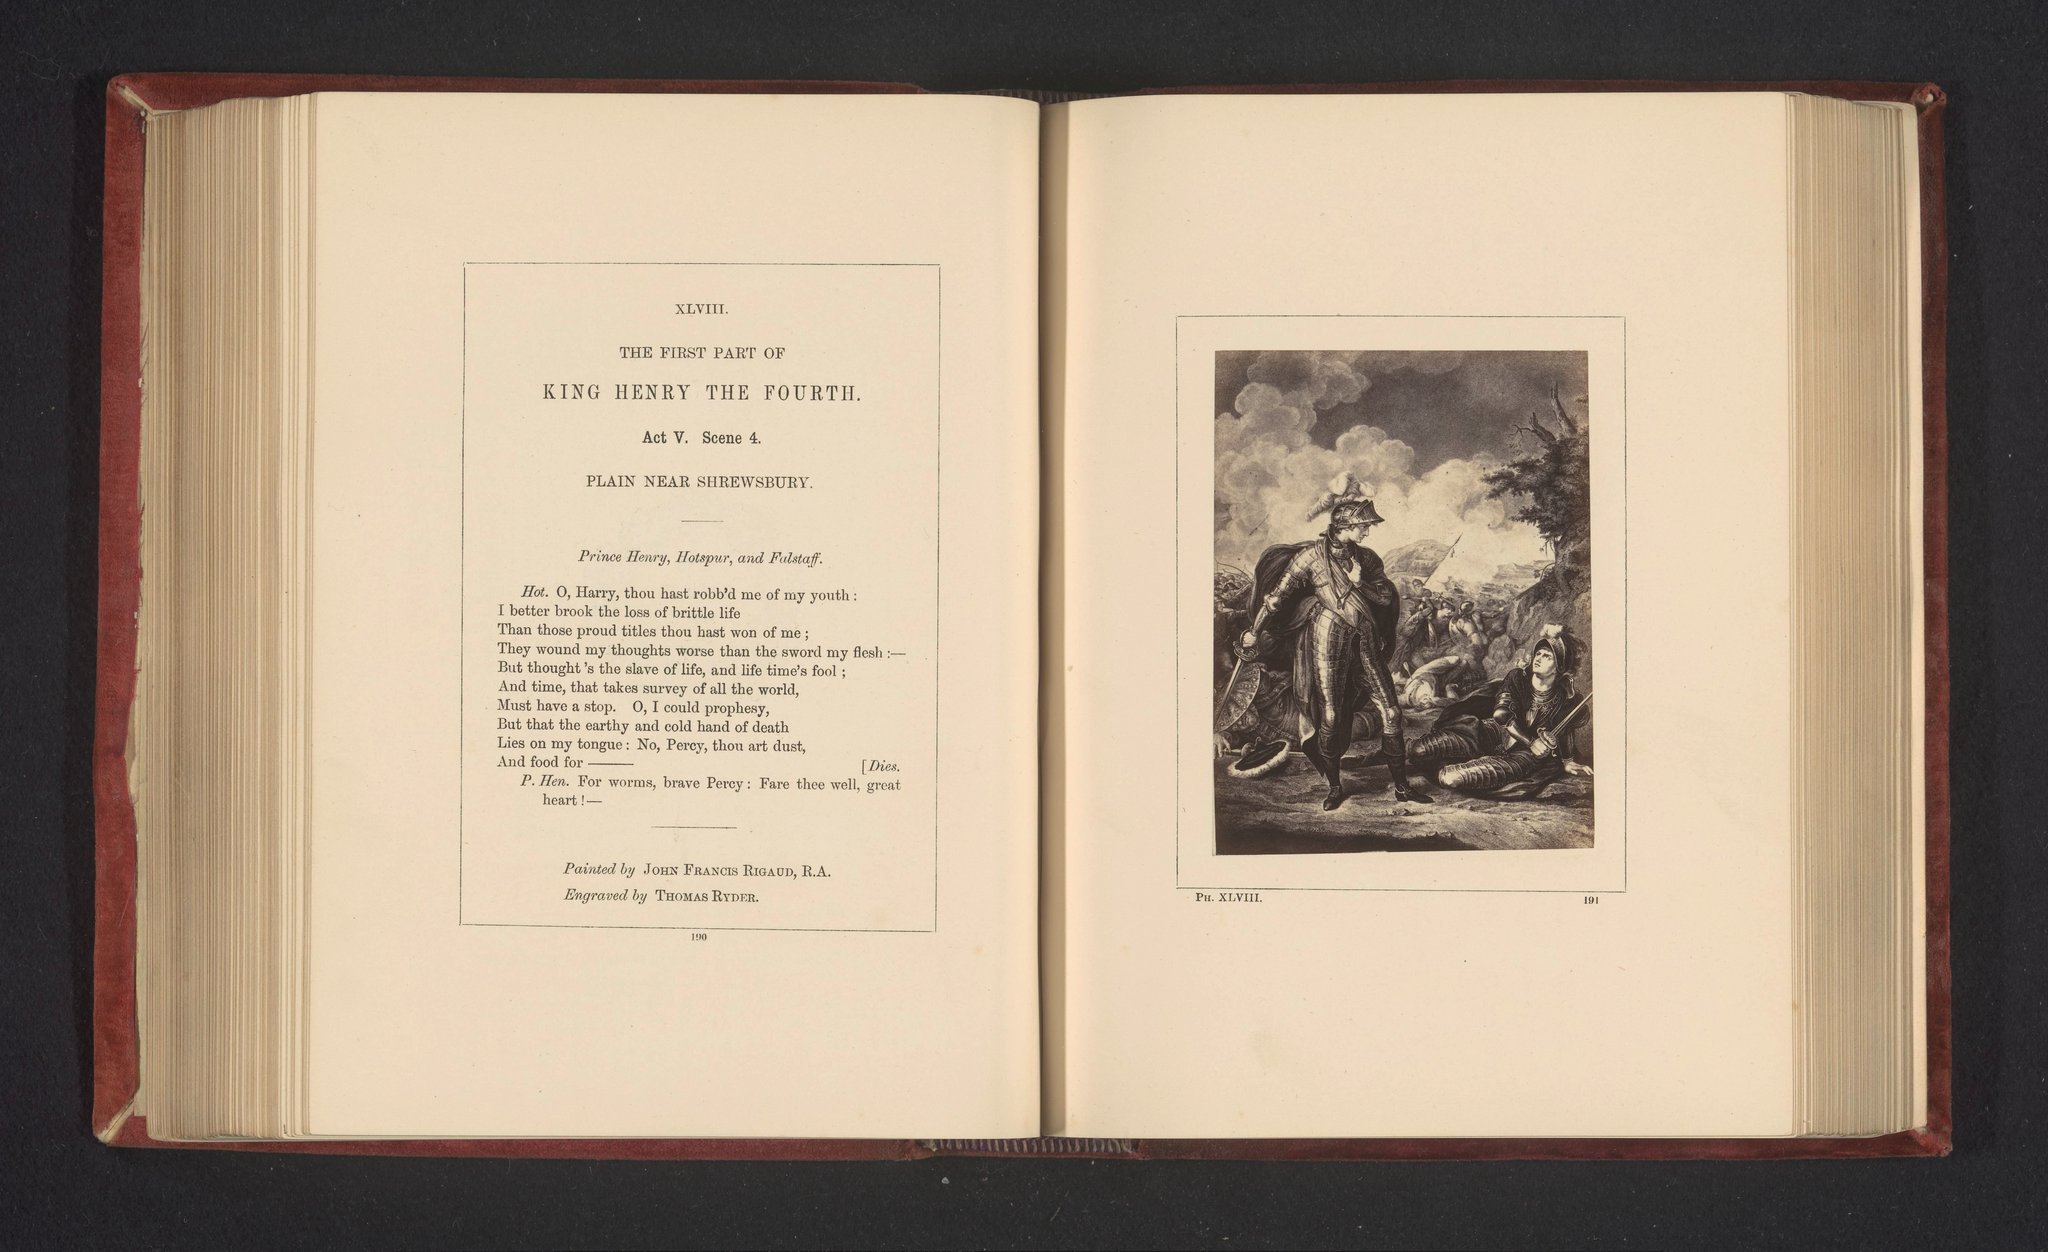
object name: page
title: Fotoreproductie van een prent naar een schilderij door John Francis Rigaud, voorstellend een scene uit Hendrik IV door William Shakespeare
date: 1854-1864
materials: photographic support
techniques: albumen print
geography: london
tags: specific works of literature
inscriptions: number: ‘Ph. XLVIII. 191’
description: Te zien is akte V, scene 4 met prins Hendrik en Sir John Falstaff in een harnas.